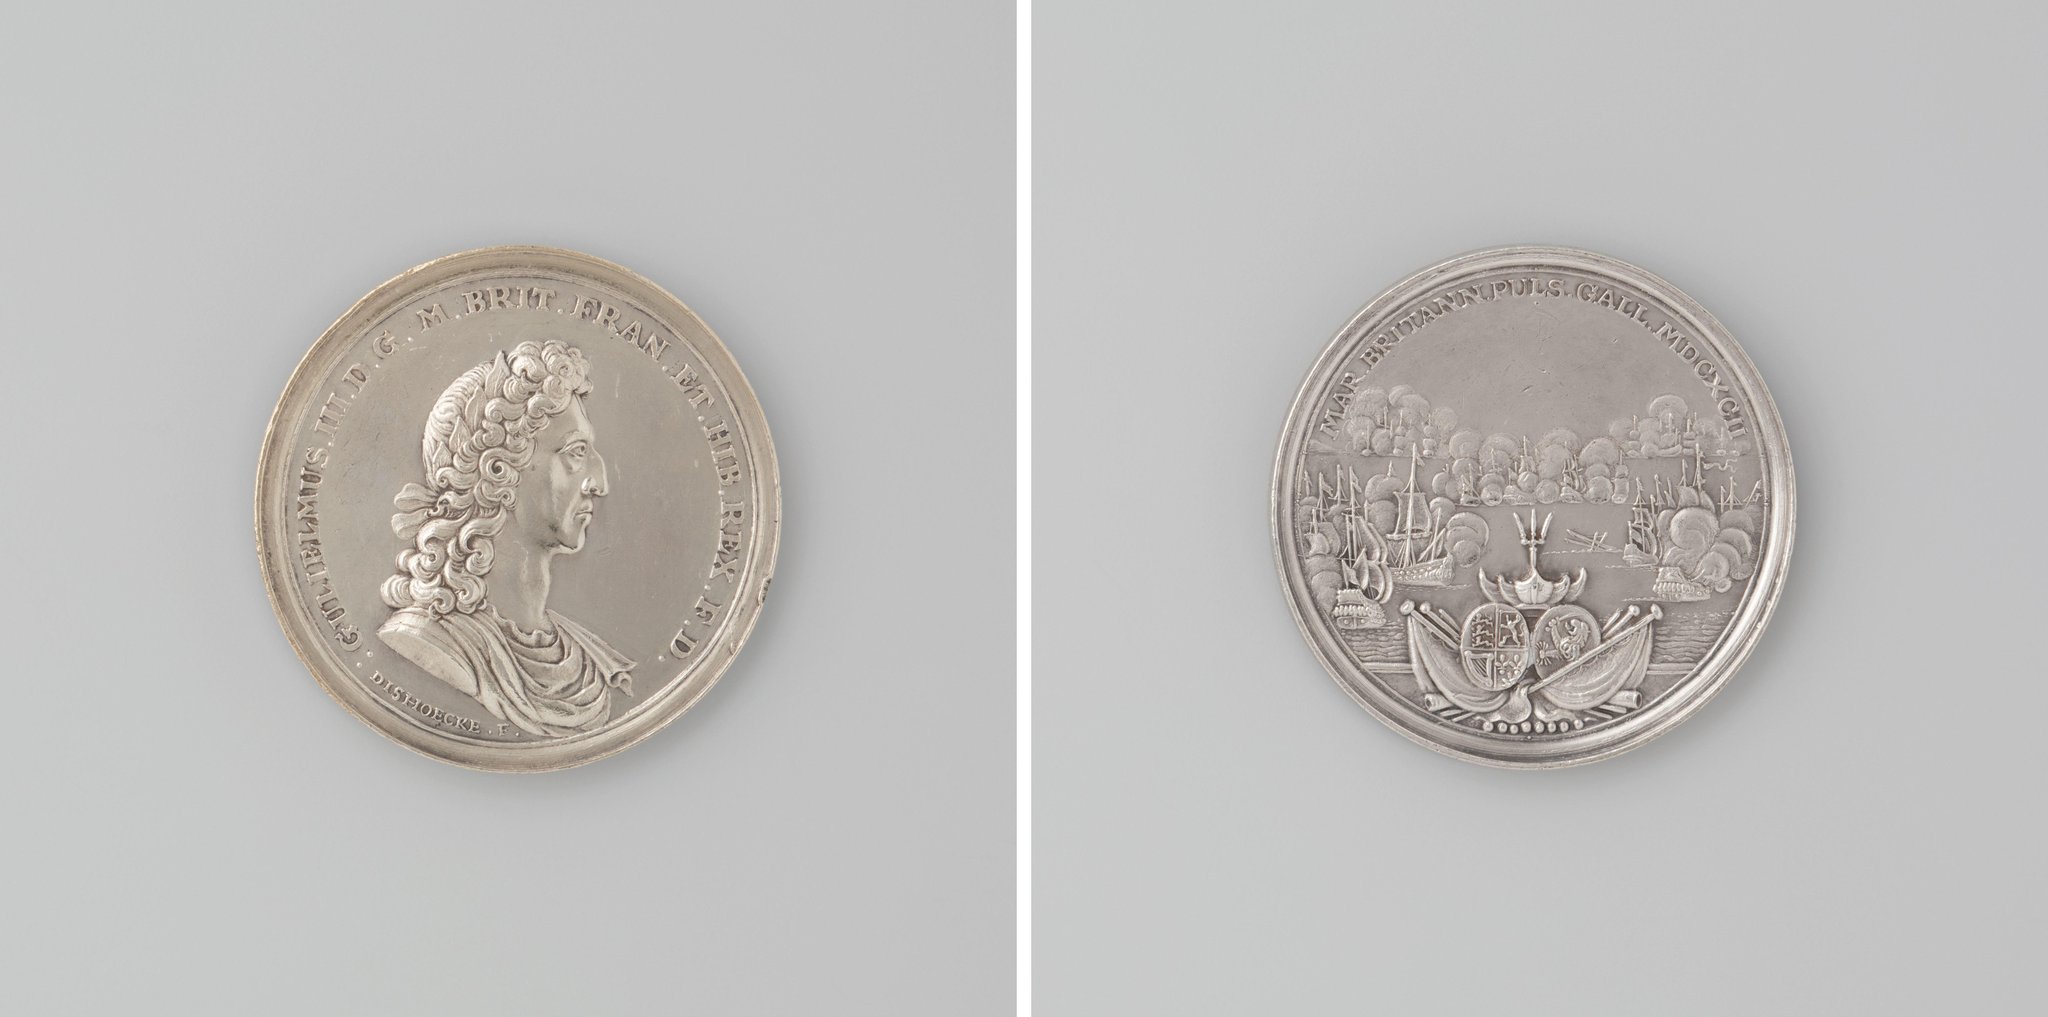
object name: history medal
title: Zeeslag bij Kaap La Hogue, de Fransen verslagen door de vloot van Engeland en Holland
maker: jacob van dishoecke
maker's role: silversmith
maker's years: 1650-1723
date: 1692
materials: silver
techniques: striking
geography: amsterdam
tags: william iii (prince of orange and king of england, scotland, and ireland)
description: Zilveren penning. Voorzijde: borststuk man met lauwerkrans binnen omschrift. Keerzijde: zeeslag met op voorgrond wapenschilden van Nederland en Engeland onder scheepskroon en drietand binnen omschrift